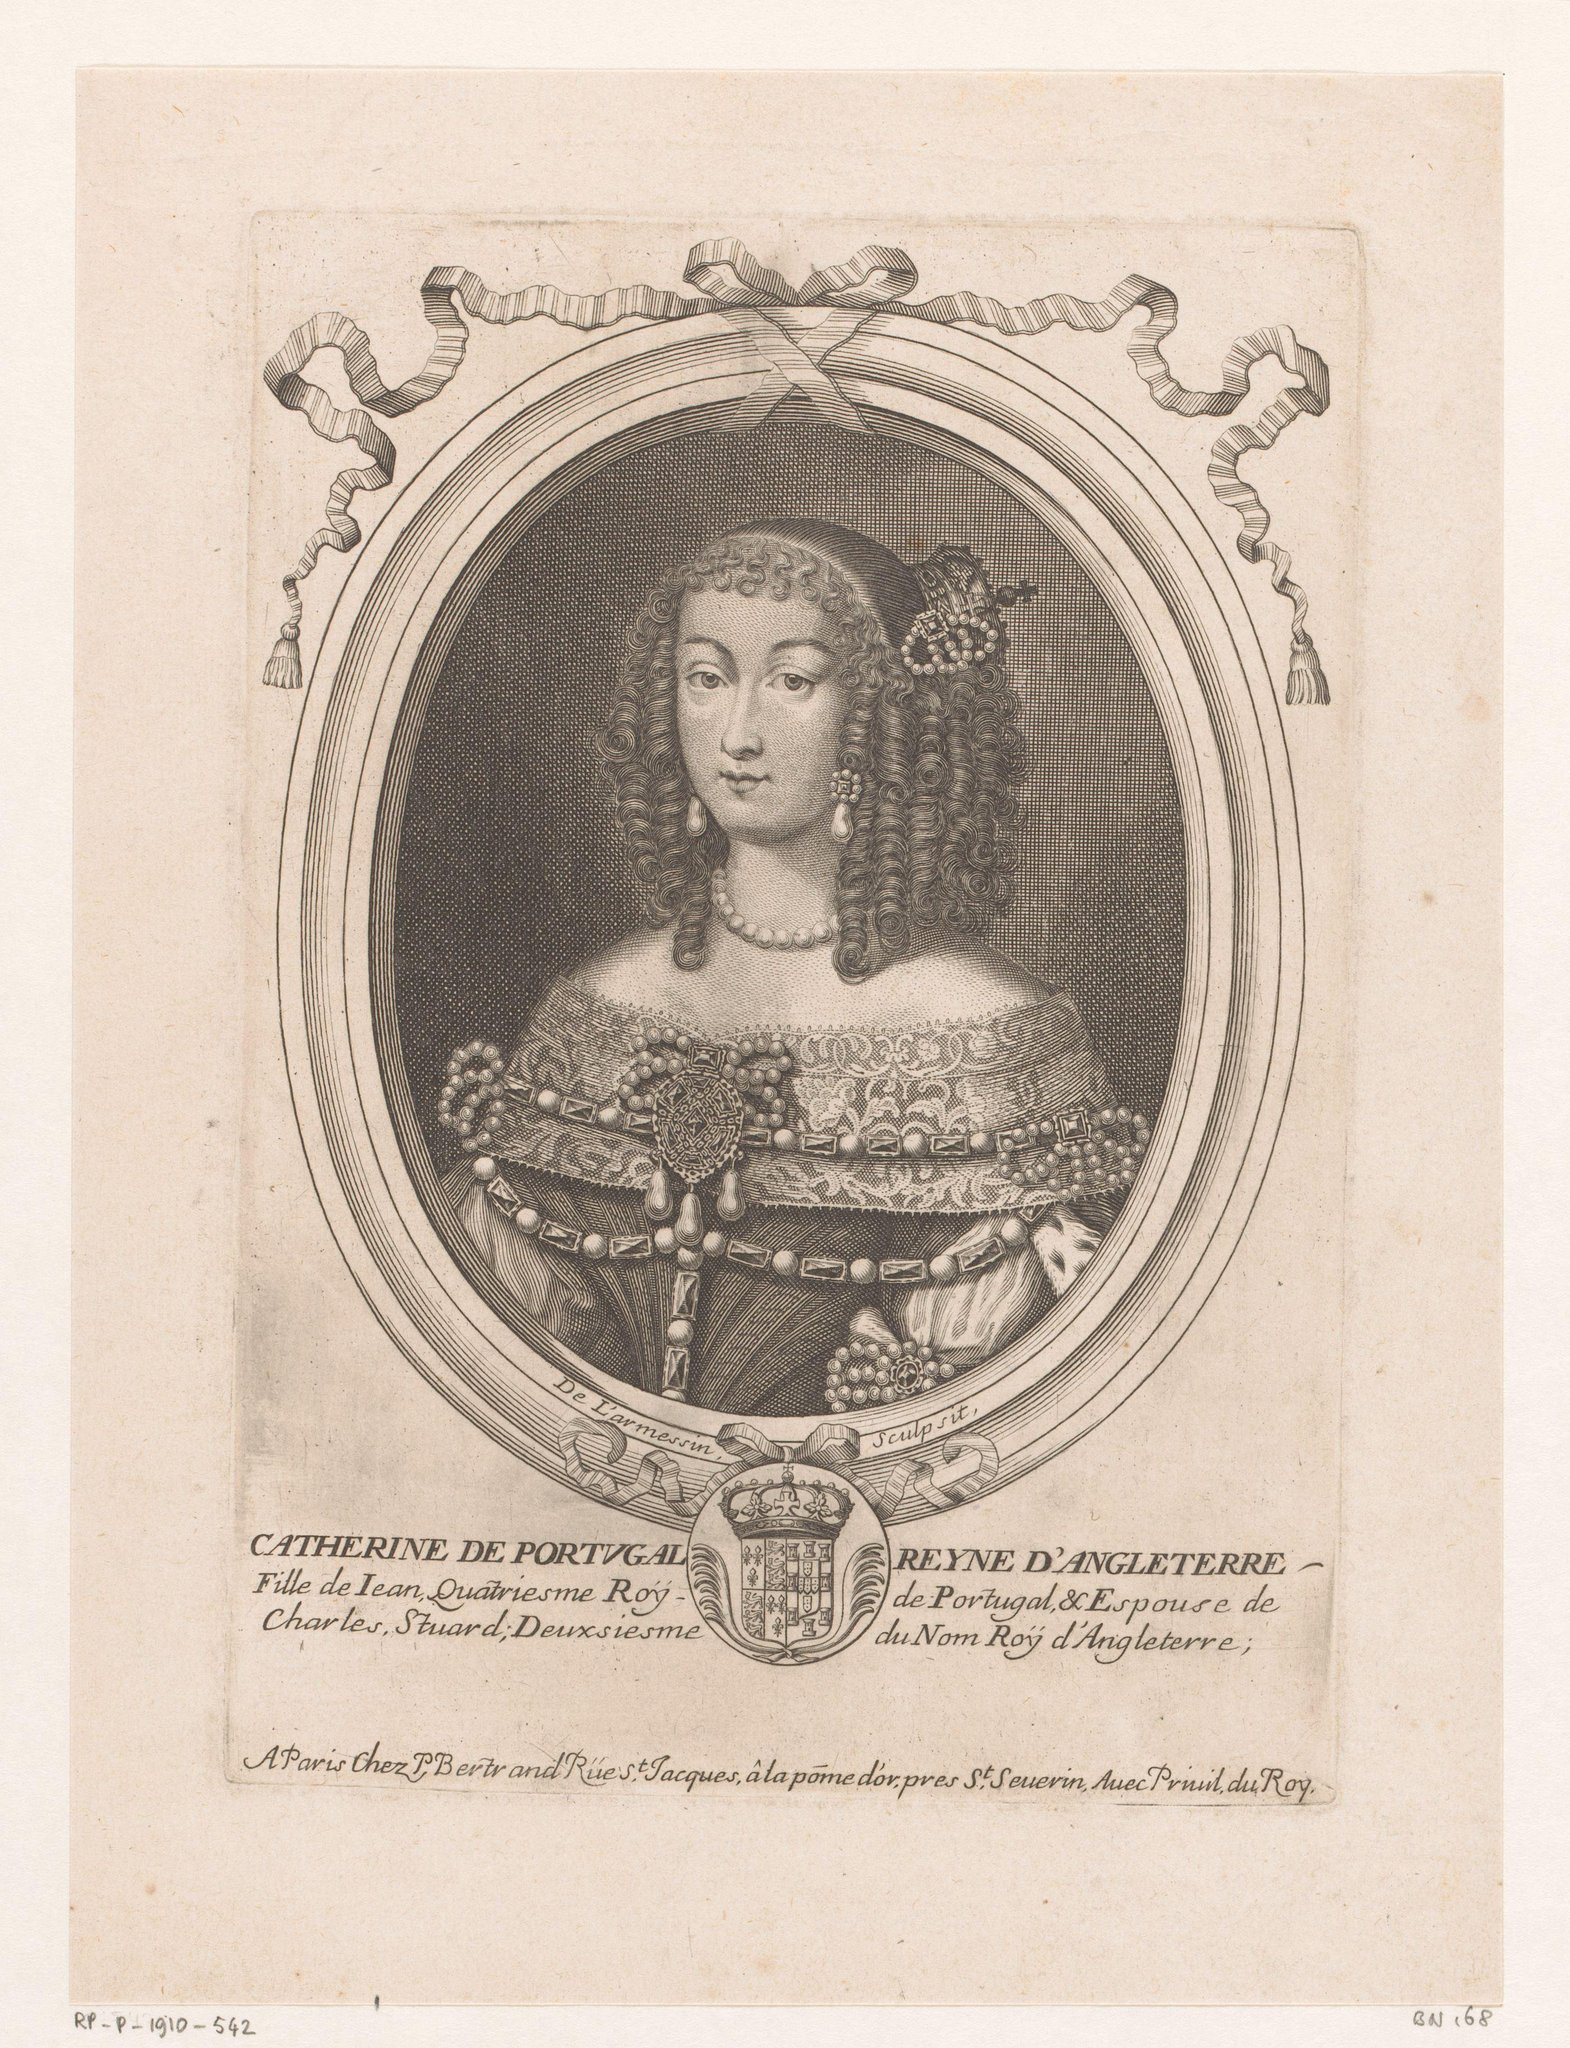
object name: print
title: Portretten van prominente figuren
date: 1642-1678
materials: paper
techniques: engraving, etching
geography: france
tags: catharina van bragança, historical persons, queen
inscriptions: collector's mark: Lugt 2228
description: Maakt deel uit van een grootschalige serie met portretten van prominente figuren. Binnen de serie bevindt zich een sectie getiteld 'Les Augustes Représentations De tous les Roys De France depuis Pharamond Iusqu'à Louys XIIII'. De serie werd respectievelijk uitgegeven door Pierre Bertrand, door zijn weduwe en door De Larmessin zelf.